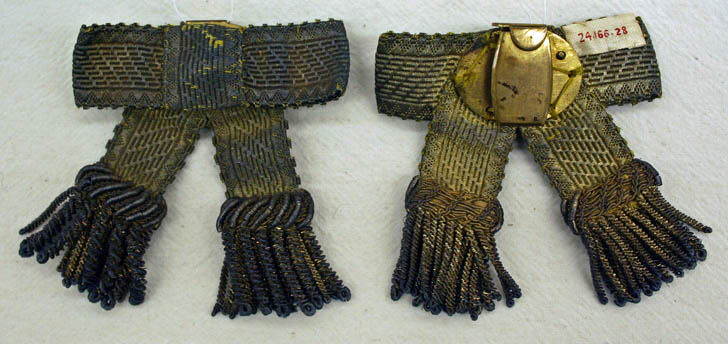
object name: garter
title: Garters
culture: french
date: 1801-1833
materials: metal thread